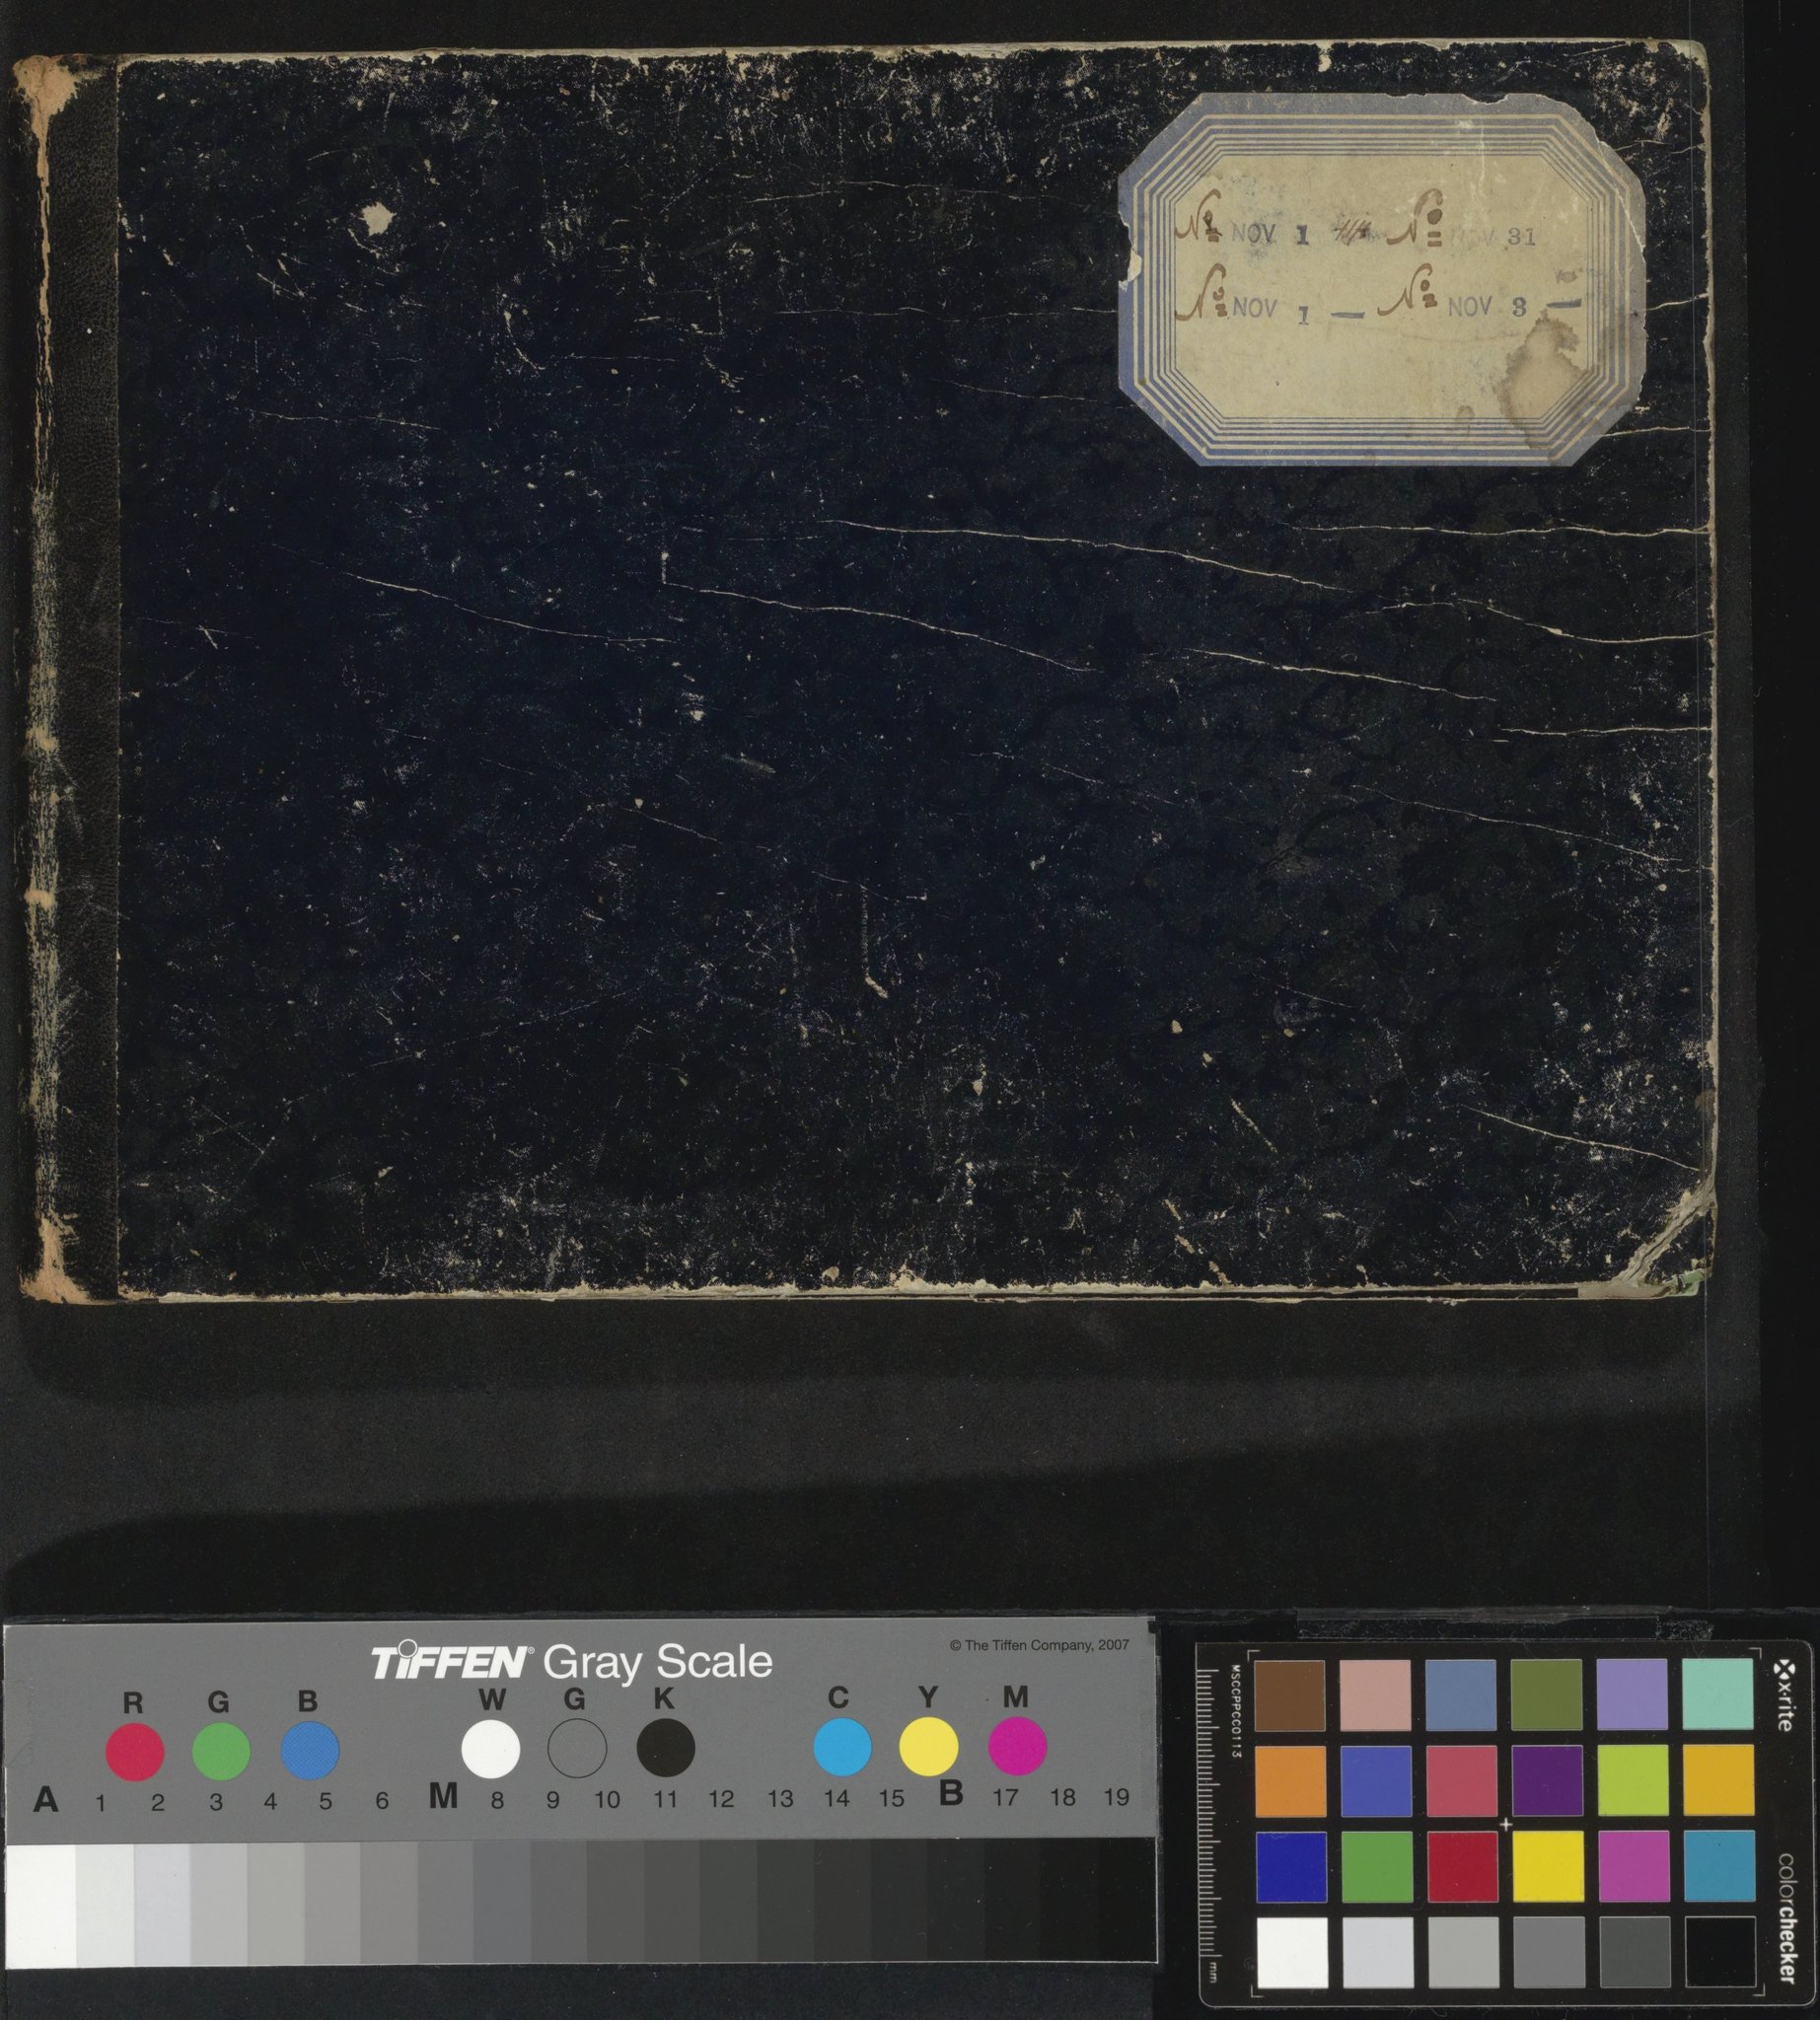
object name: sketchbook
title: Schetsboek met 25 bladen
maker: willem roelofs (i)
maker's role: draughtsman, painter, print maker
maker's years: 1822-1897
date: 1846-1851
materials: cardboard, chalk, paper, pencil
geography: belgium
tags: landscapes with waters, waterscapes, seascapes (in the temperate zone), landscapes (+ landscape with figures, staffage), farm or solitary house in landscape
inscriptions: date: ‘Clonet à Trenes/ cadw g[...]r D 1 m sur 80 cm.’, annotation: ‘NOV 1.../ NOV 3 __’, signature and date: ‘W. Roelofs 1851’, annotation: ‘[...]/ convoi Bru[...]pl naar [...]épi[...]stèew/ Rep[...] ammm[...] naar Spa./ van spa op Dickisch [...] 2 ru[...]’, label: ‘No NOV 1 141? No NOV 31/ No NOV 1 __ No NOV 3__’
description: De volgende bladen uit het schetsboek zijn blanco: 1(V) t/m 5(V), 8(V), 9(V), 21(V) t/m 23(V). Het merendeel van de schetsen in het schetsboek is gestempeld met de datumaanduiding 'NOV __'. Het is niet bekend of dit door de kunstenaar zelf, in zijn tijd of door een latere hand is gedaan.